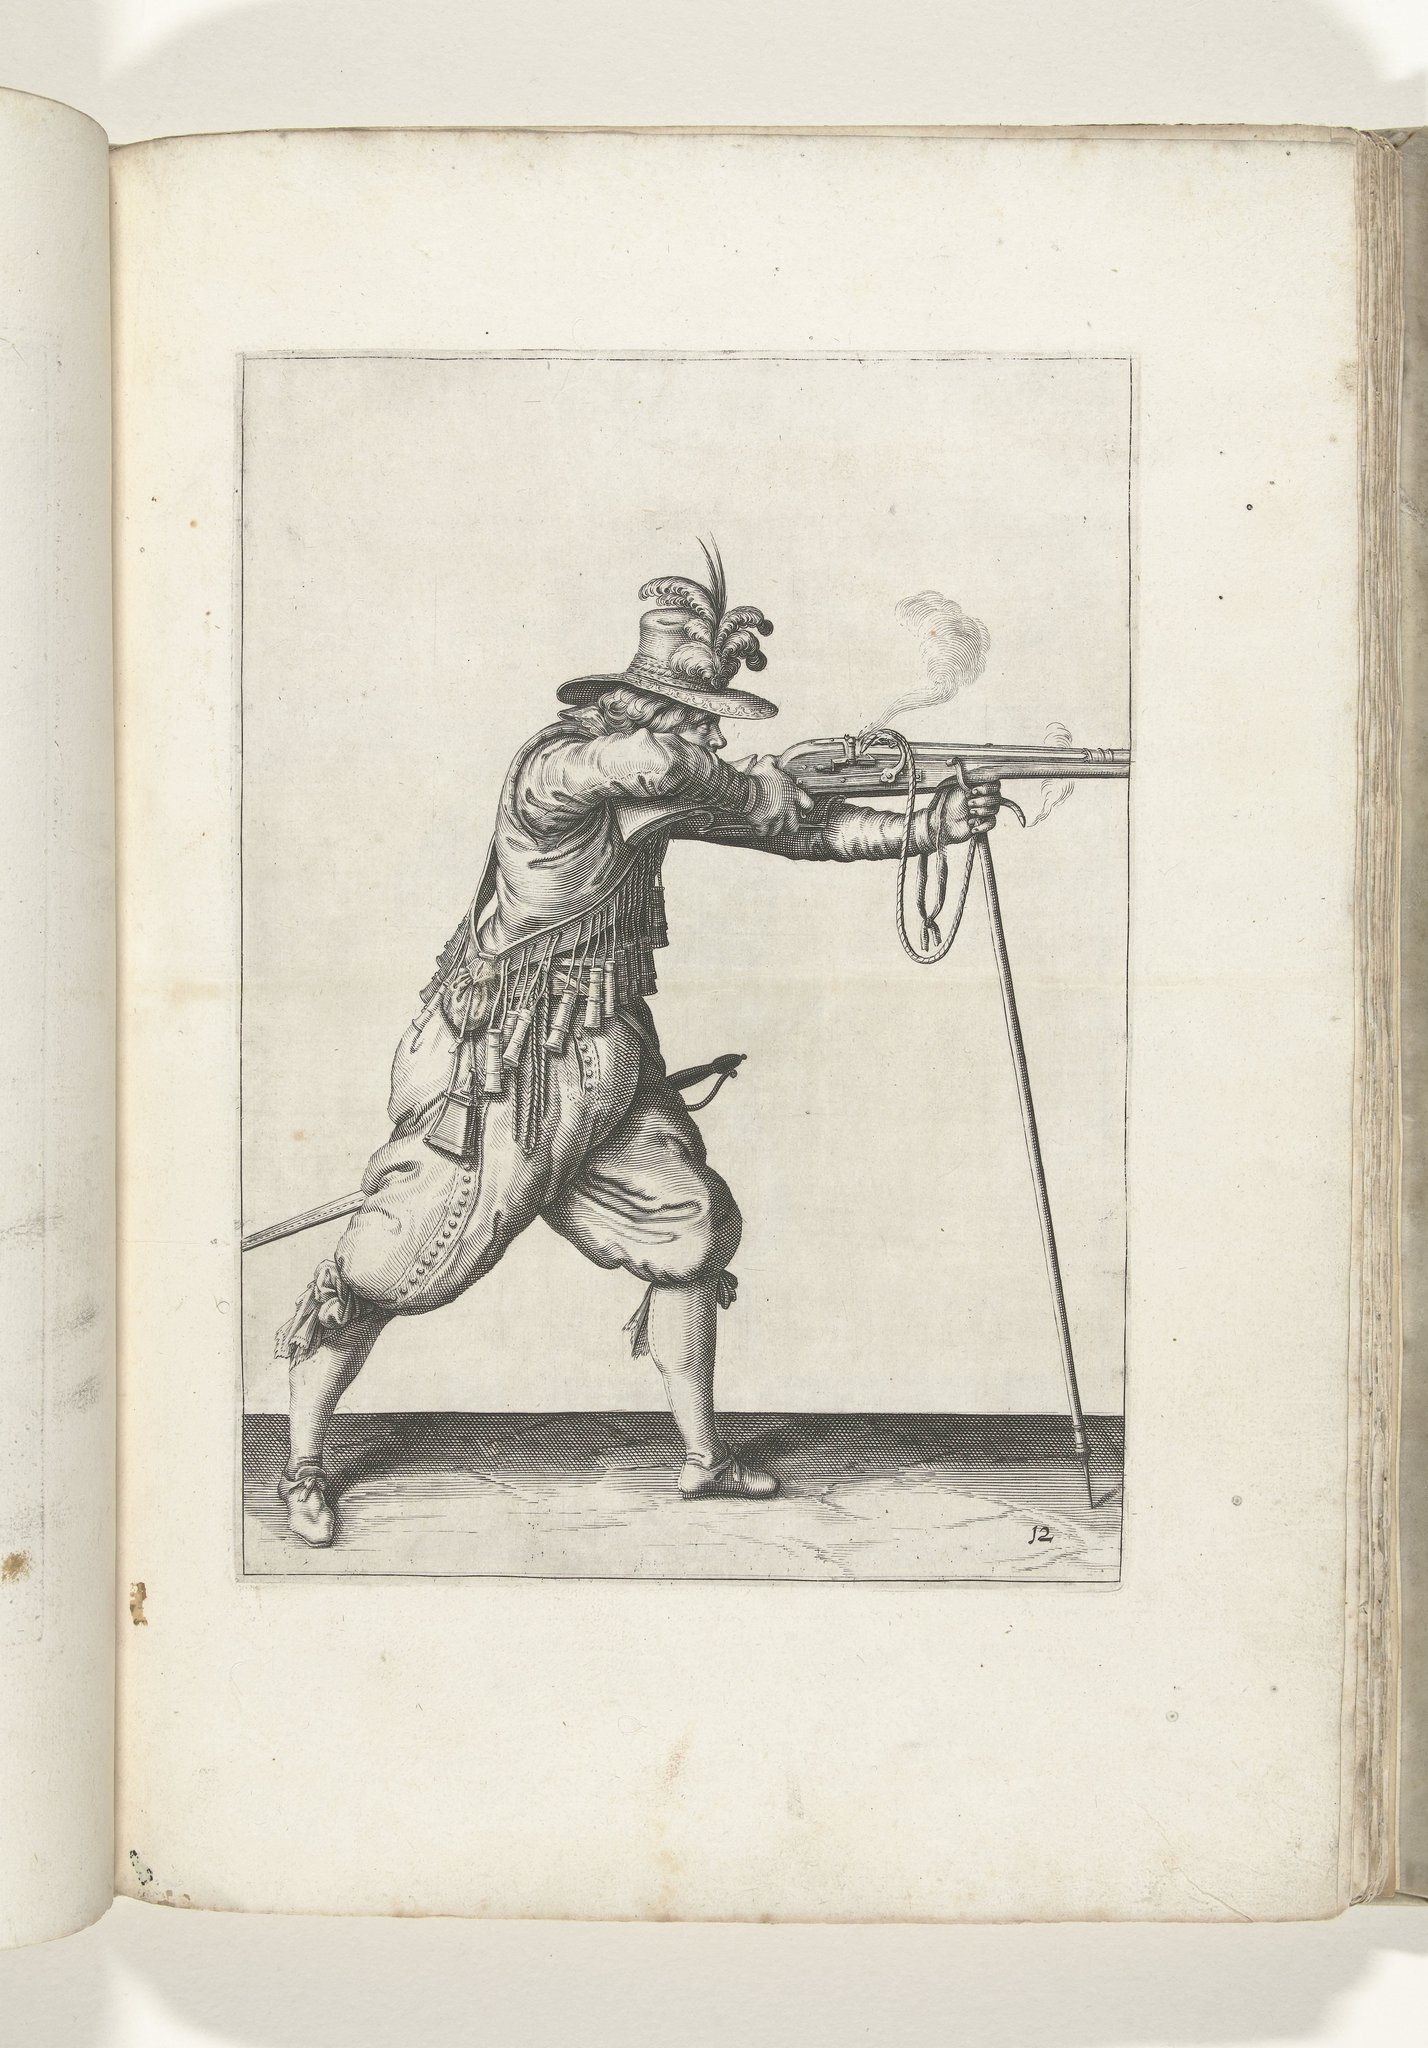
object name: print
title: Soldaat die zijn musket, steunend op zijn furket, afvuurt (nr. 12), ca. 1600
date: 1597-1607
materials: paper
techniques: engraving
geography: the hague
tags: the hague, maurice (prince of orange), handling of weapons ~ military training, weapons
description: Een soldaat, ten voeten uit, naar rechts, die een musket (een bepaald type vuurwapen) met beide handen richt op een doelwit, de loop steunend op een furket (musketvork), en afvuurt (nr. 12), ca. 1600. Plaat 12 in de instructies voor het hanteren van het musket: Corte onderrechtinghe op de figuerliicke afbeeldinghe, soo veel aengaet het recht ghebruyck vant Musquet. Onderdeel van de illustraties in: J. de Gheyn, Wapenhandelinghe van Roers Musquetten ende spiessen, 's-Gravenhage, 1607. Krijgswezen rond 1600.